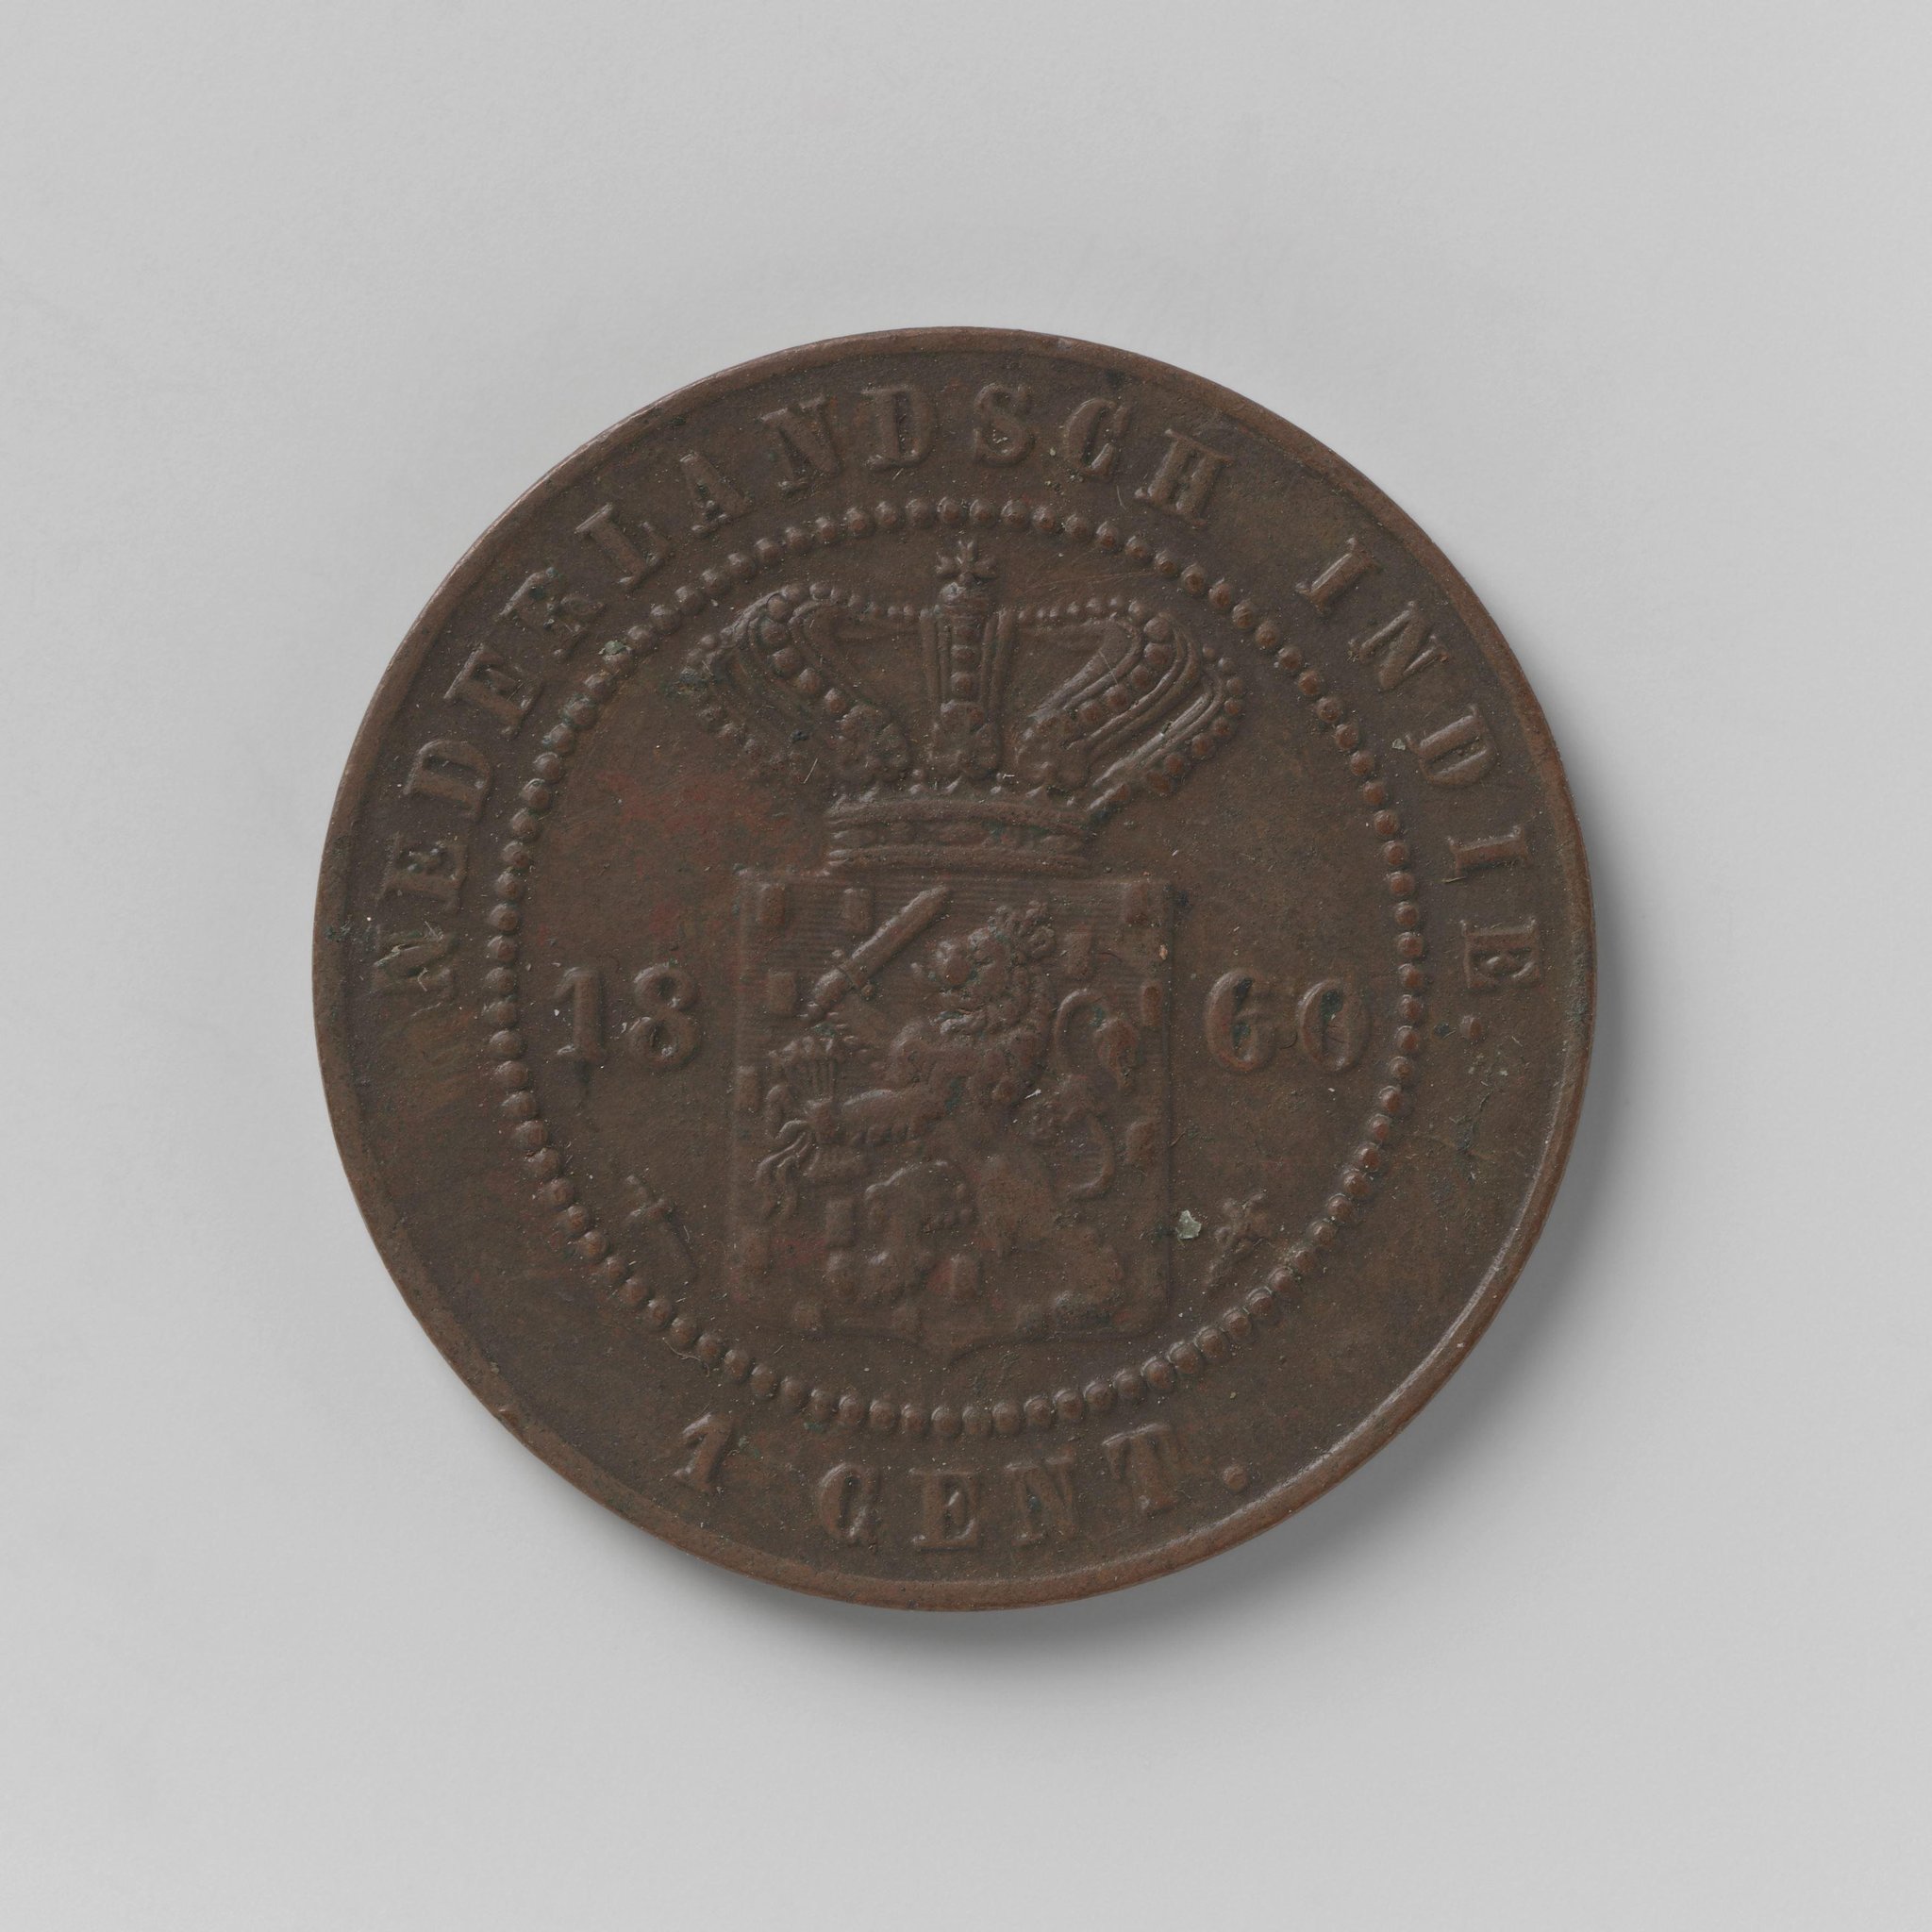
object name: coin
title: Nederlands Indië, cent,1860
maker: willem iii (koning der nederlanden)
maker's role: koning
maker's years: 1817-1890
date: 1860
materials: copper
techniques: striking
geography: utrecht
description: Koperen munt. Voorzijde: tussen jaartal gekroond rijkswapenschild. Boven kroon landsaanduiding en onder wapenschild waarde-aanduiding. Keerzijde: tweeregelig Maleis opschrift in Arabische tekens, waaromheen omschrift in het Javaans. Gladde rand.